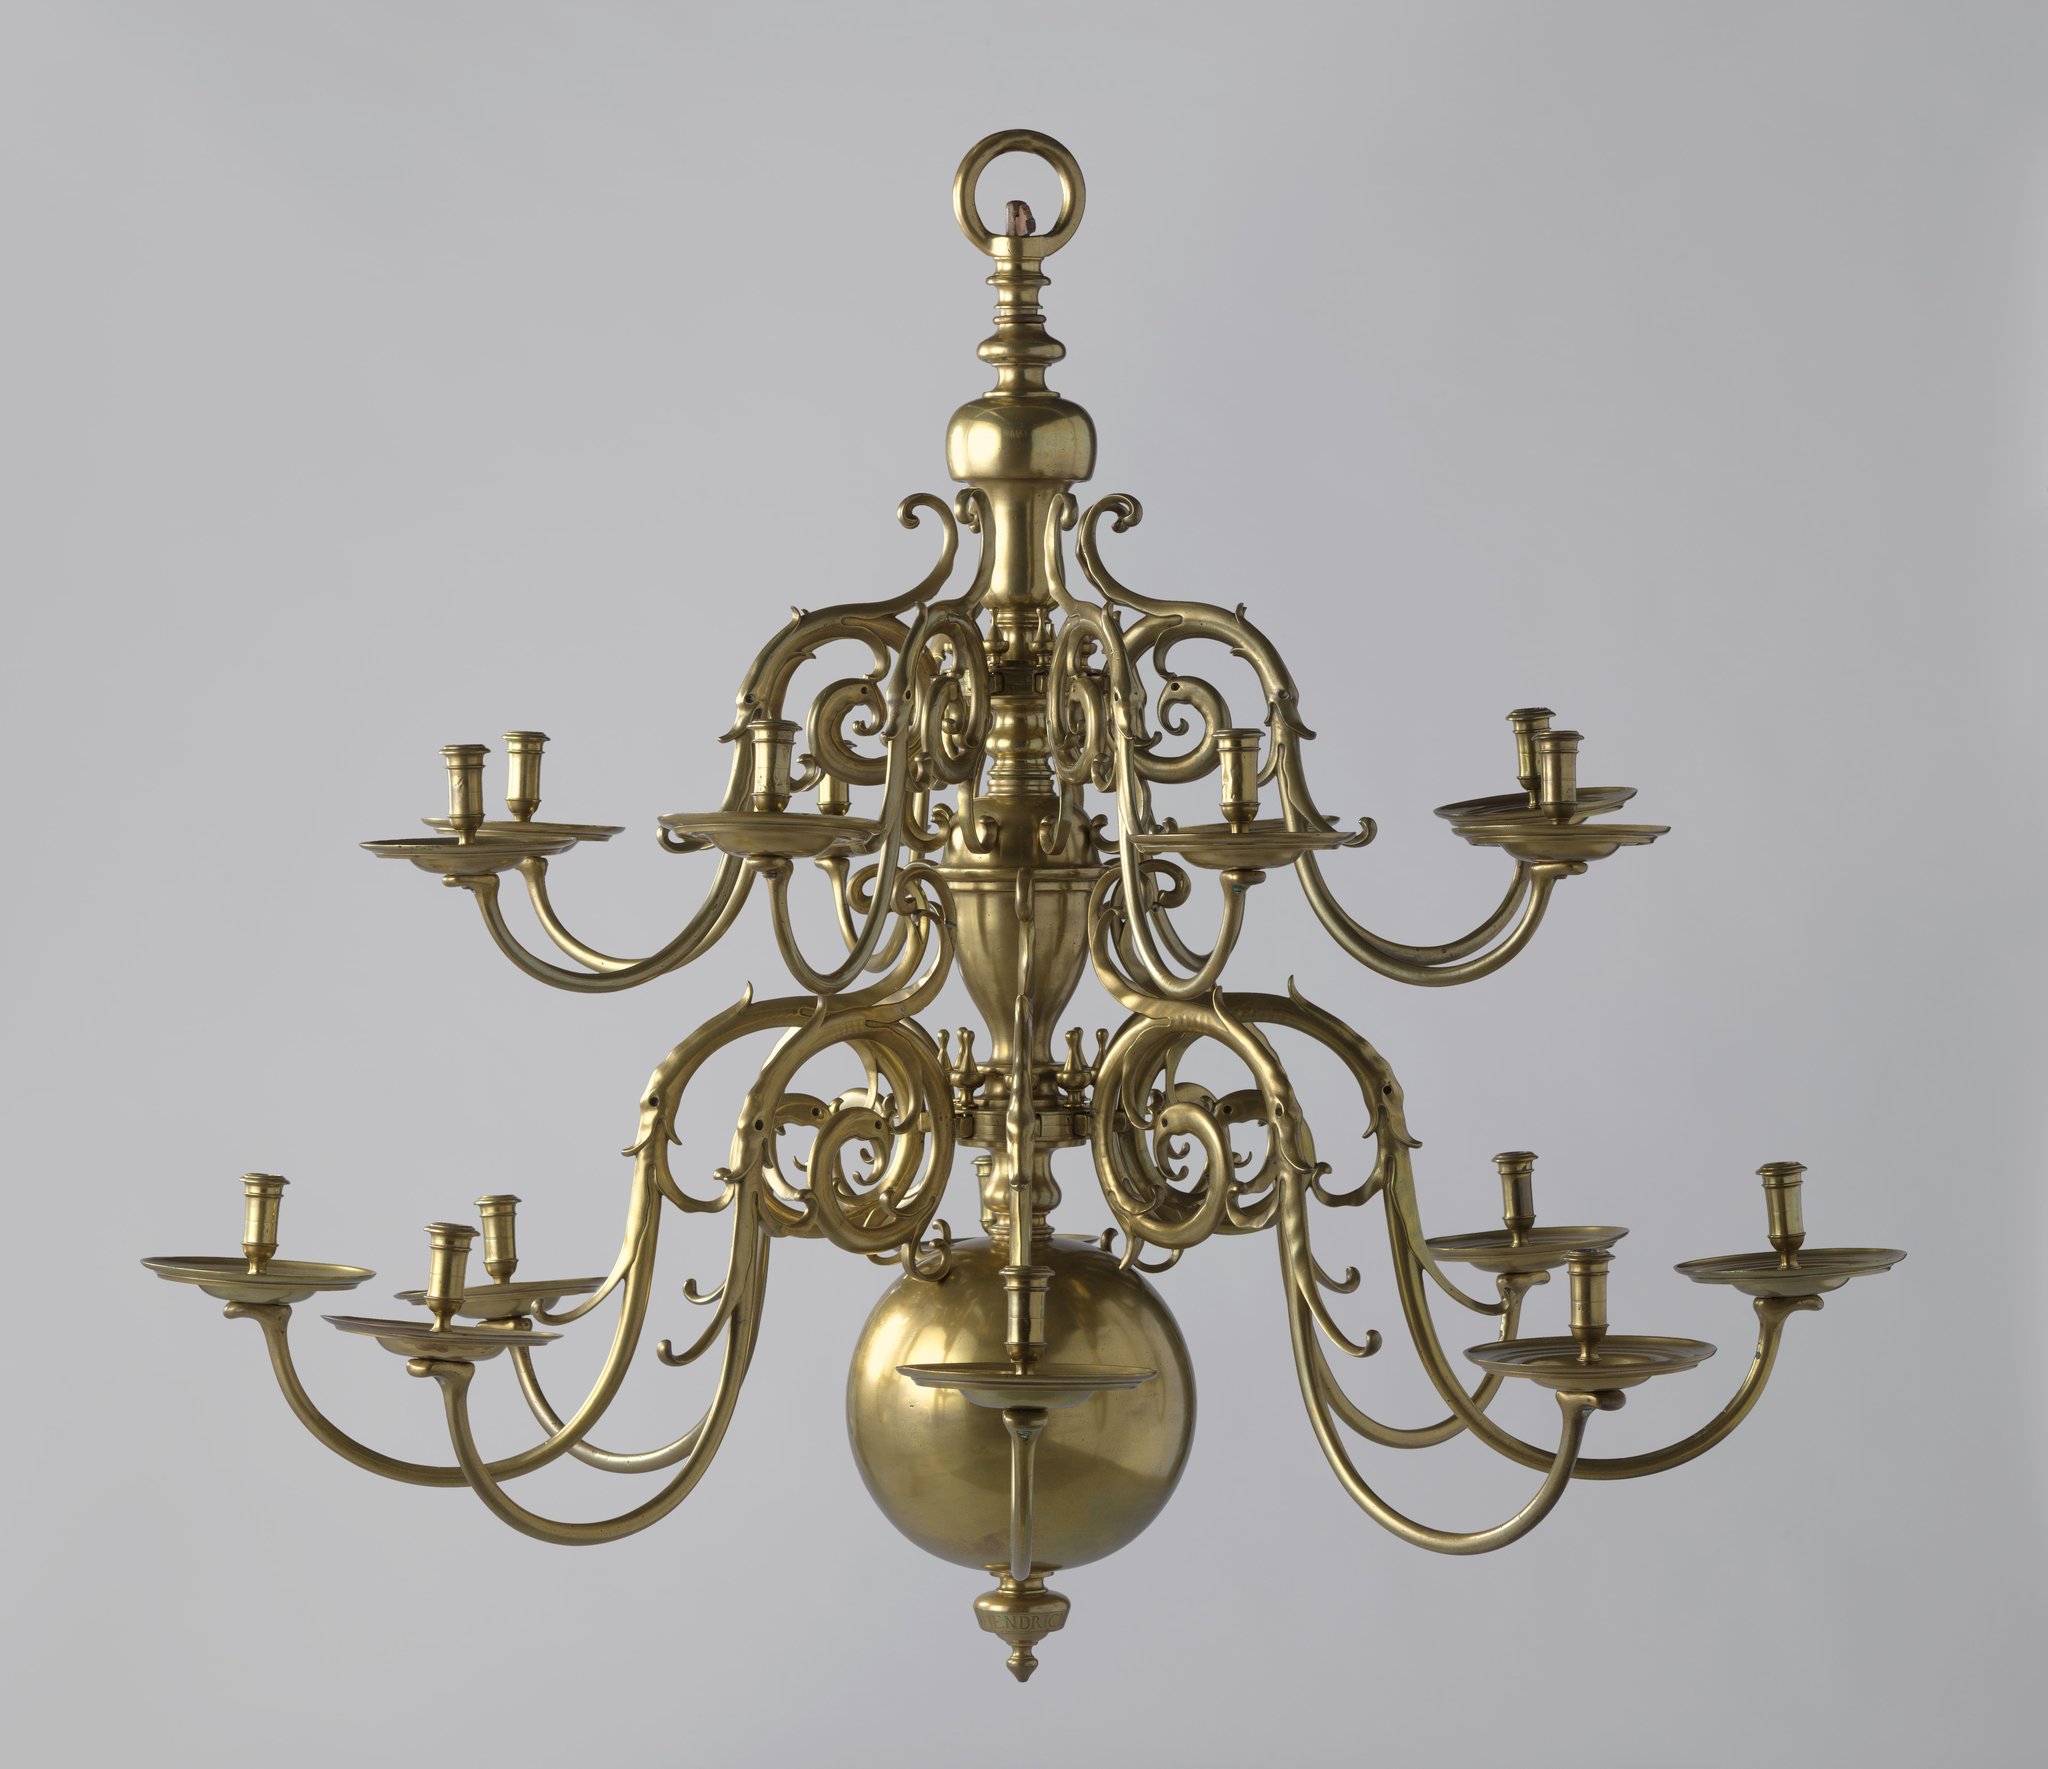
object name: chandelier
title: Stamdeel van kaarsenkroon van twee hoogten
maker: Anonymous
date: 1650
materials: brass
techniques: casting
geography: amsterdam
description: Het met gegroefde ringen versierde onderste stamdeel is bovenaan balustervormg, gaat vervolgens over in een standring met openingen voor de acht armen. Zij zijn gemerkt met de cijfers een t/m acht ingeslagen links van de opening. De standring heeft dichtgemaakte, ronde gaten, die er op wijzen dat de kaarsenkroon ooit geëlectrifieerd is geweest.